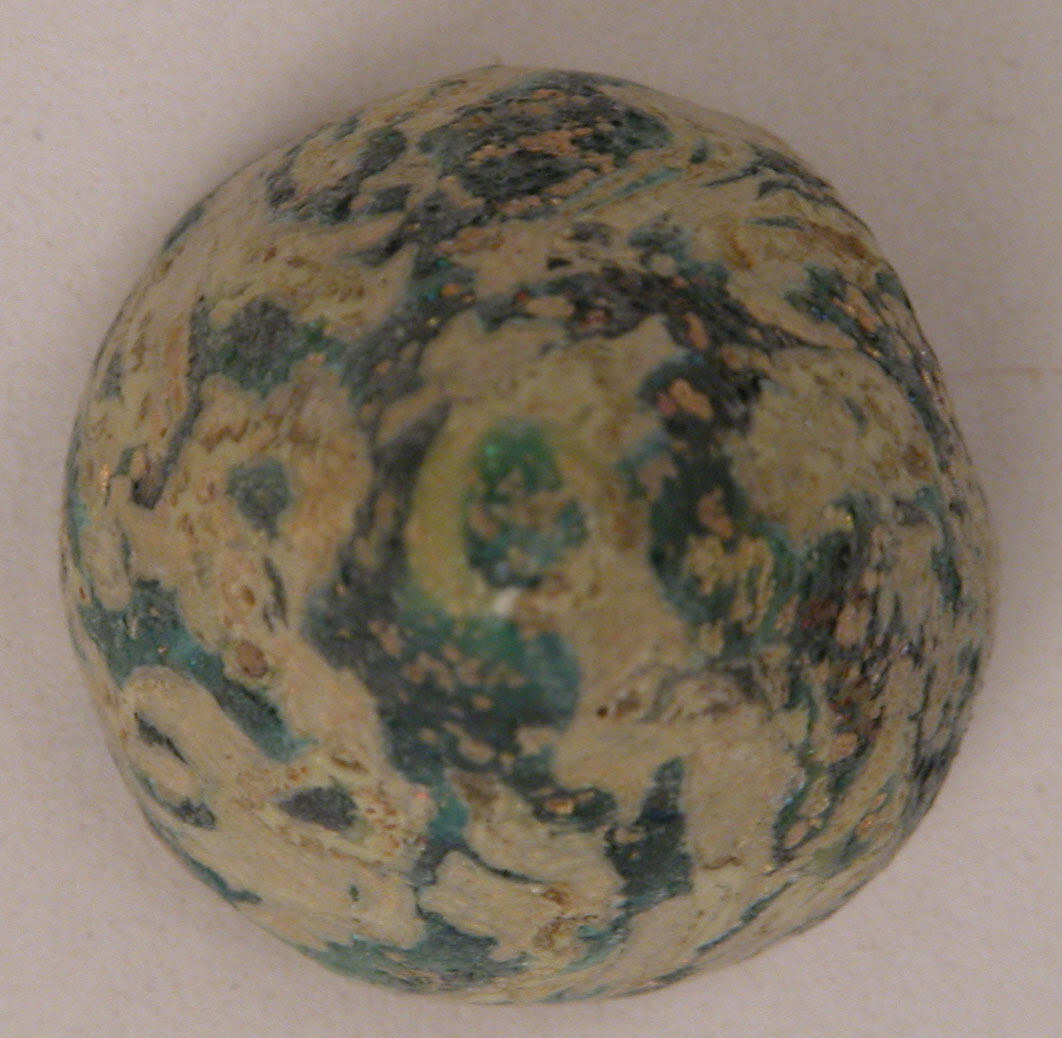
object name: gaming piece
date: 801-1000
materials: glass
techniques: cutting, polish, tooling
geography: islamic lands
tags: games